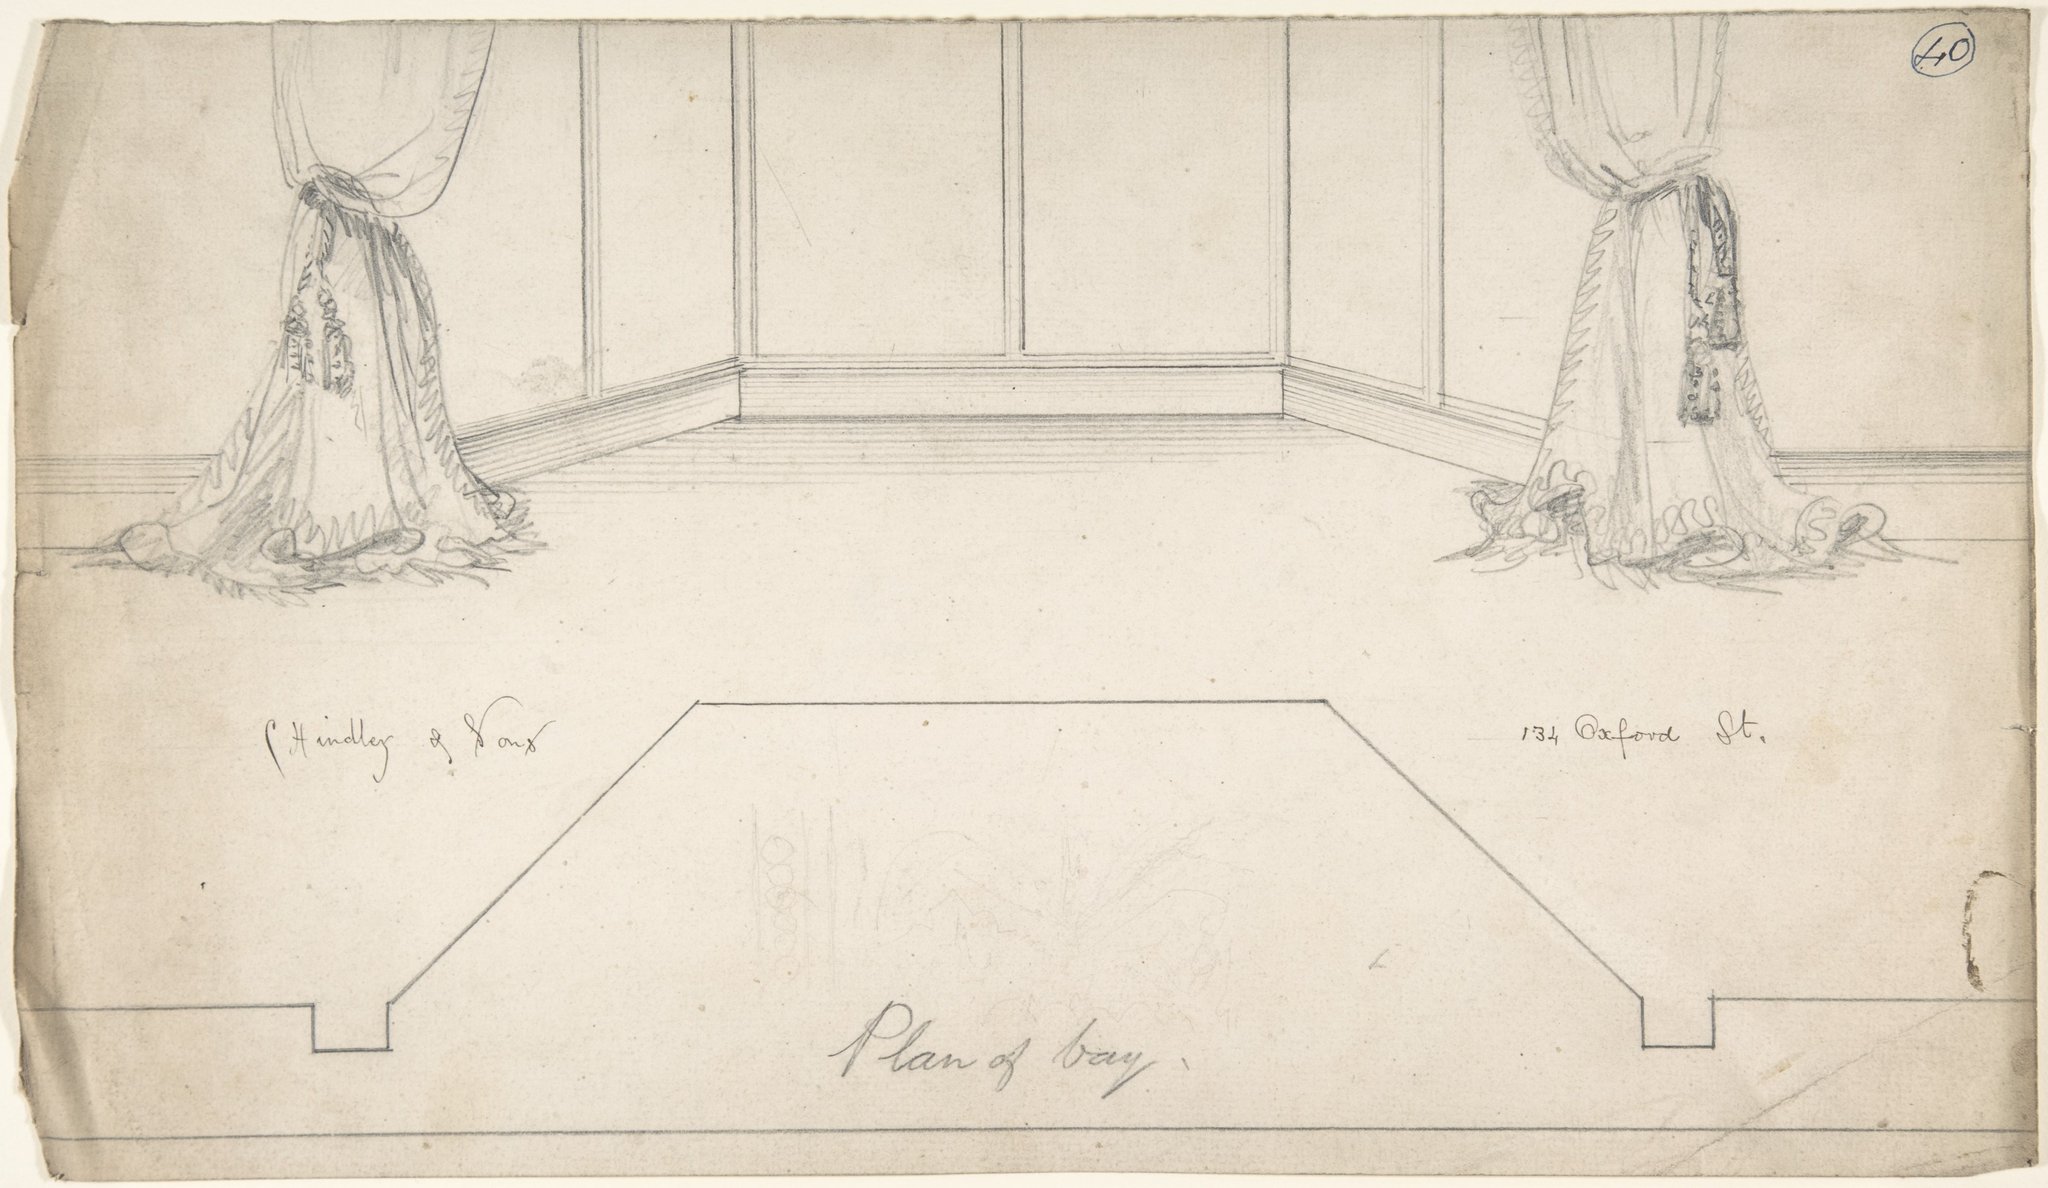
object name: drawing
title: Plan for Window Bay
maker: charles hindley and sons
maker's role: artist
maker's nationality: british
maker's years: 1841-1917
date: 1841-1884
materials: graphite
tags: architecture